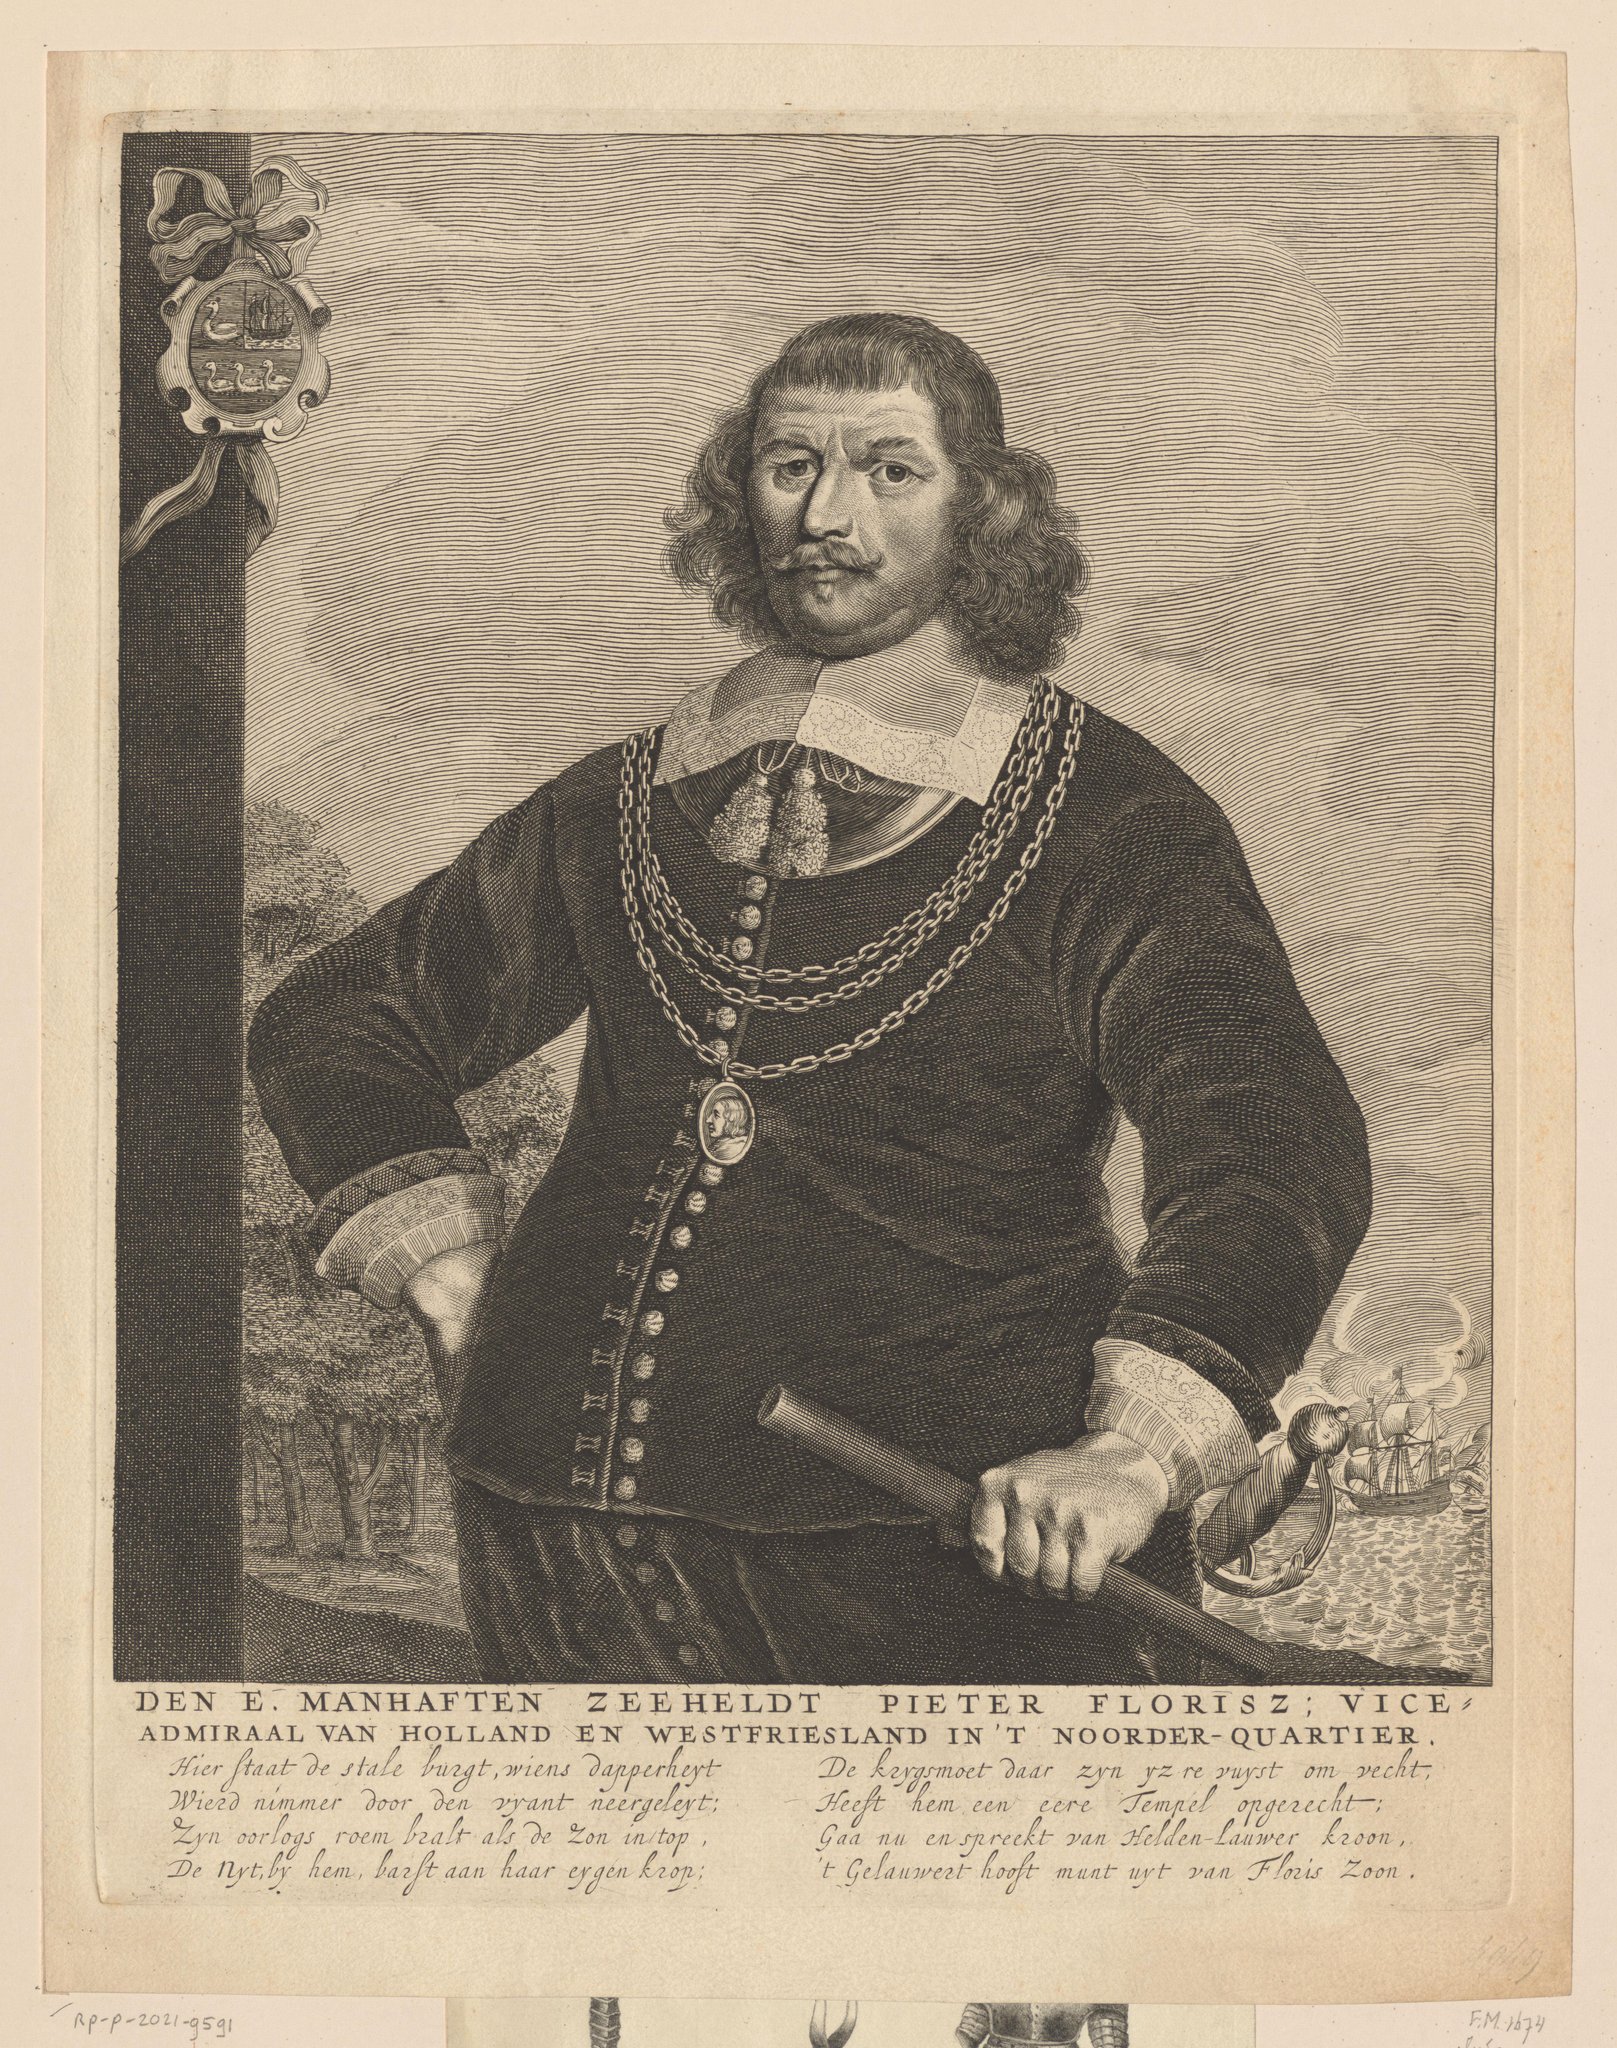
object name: print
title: Portret van Pieter Florisse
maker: Anonymous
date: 1658-1708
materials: paper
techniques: engraving, etching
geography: northern netherlands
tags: sailing-ship, sailing-boat, historical persons, commander-in-chief, admiral, armorial bearing, heraldry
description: Met achtregelig lofdicht in twee kolommen in het Nederlands.